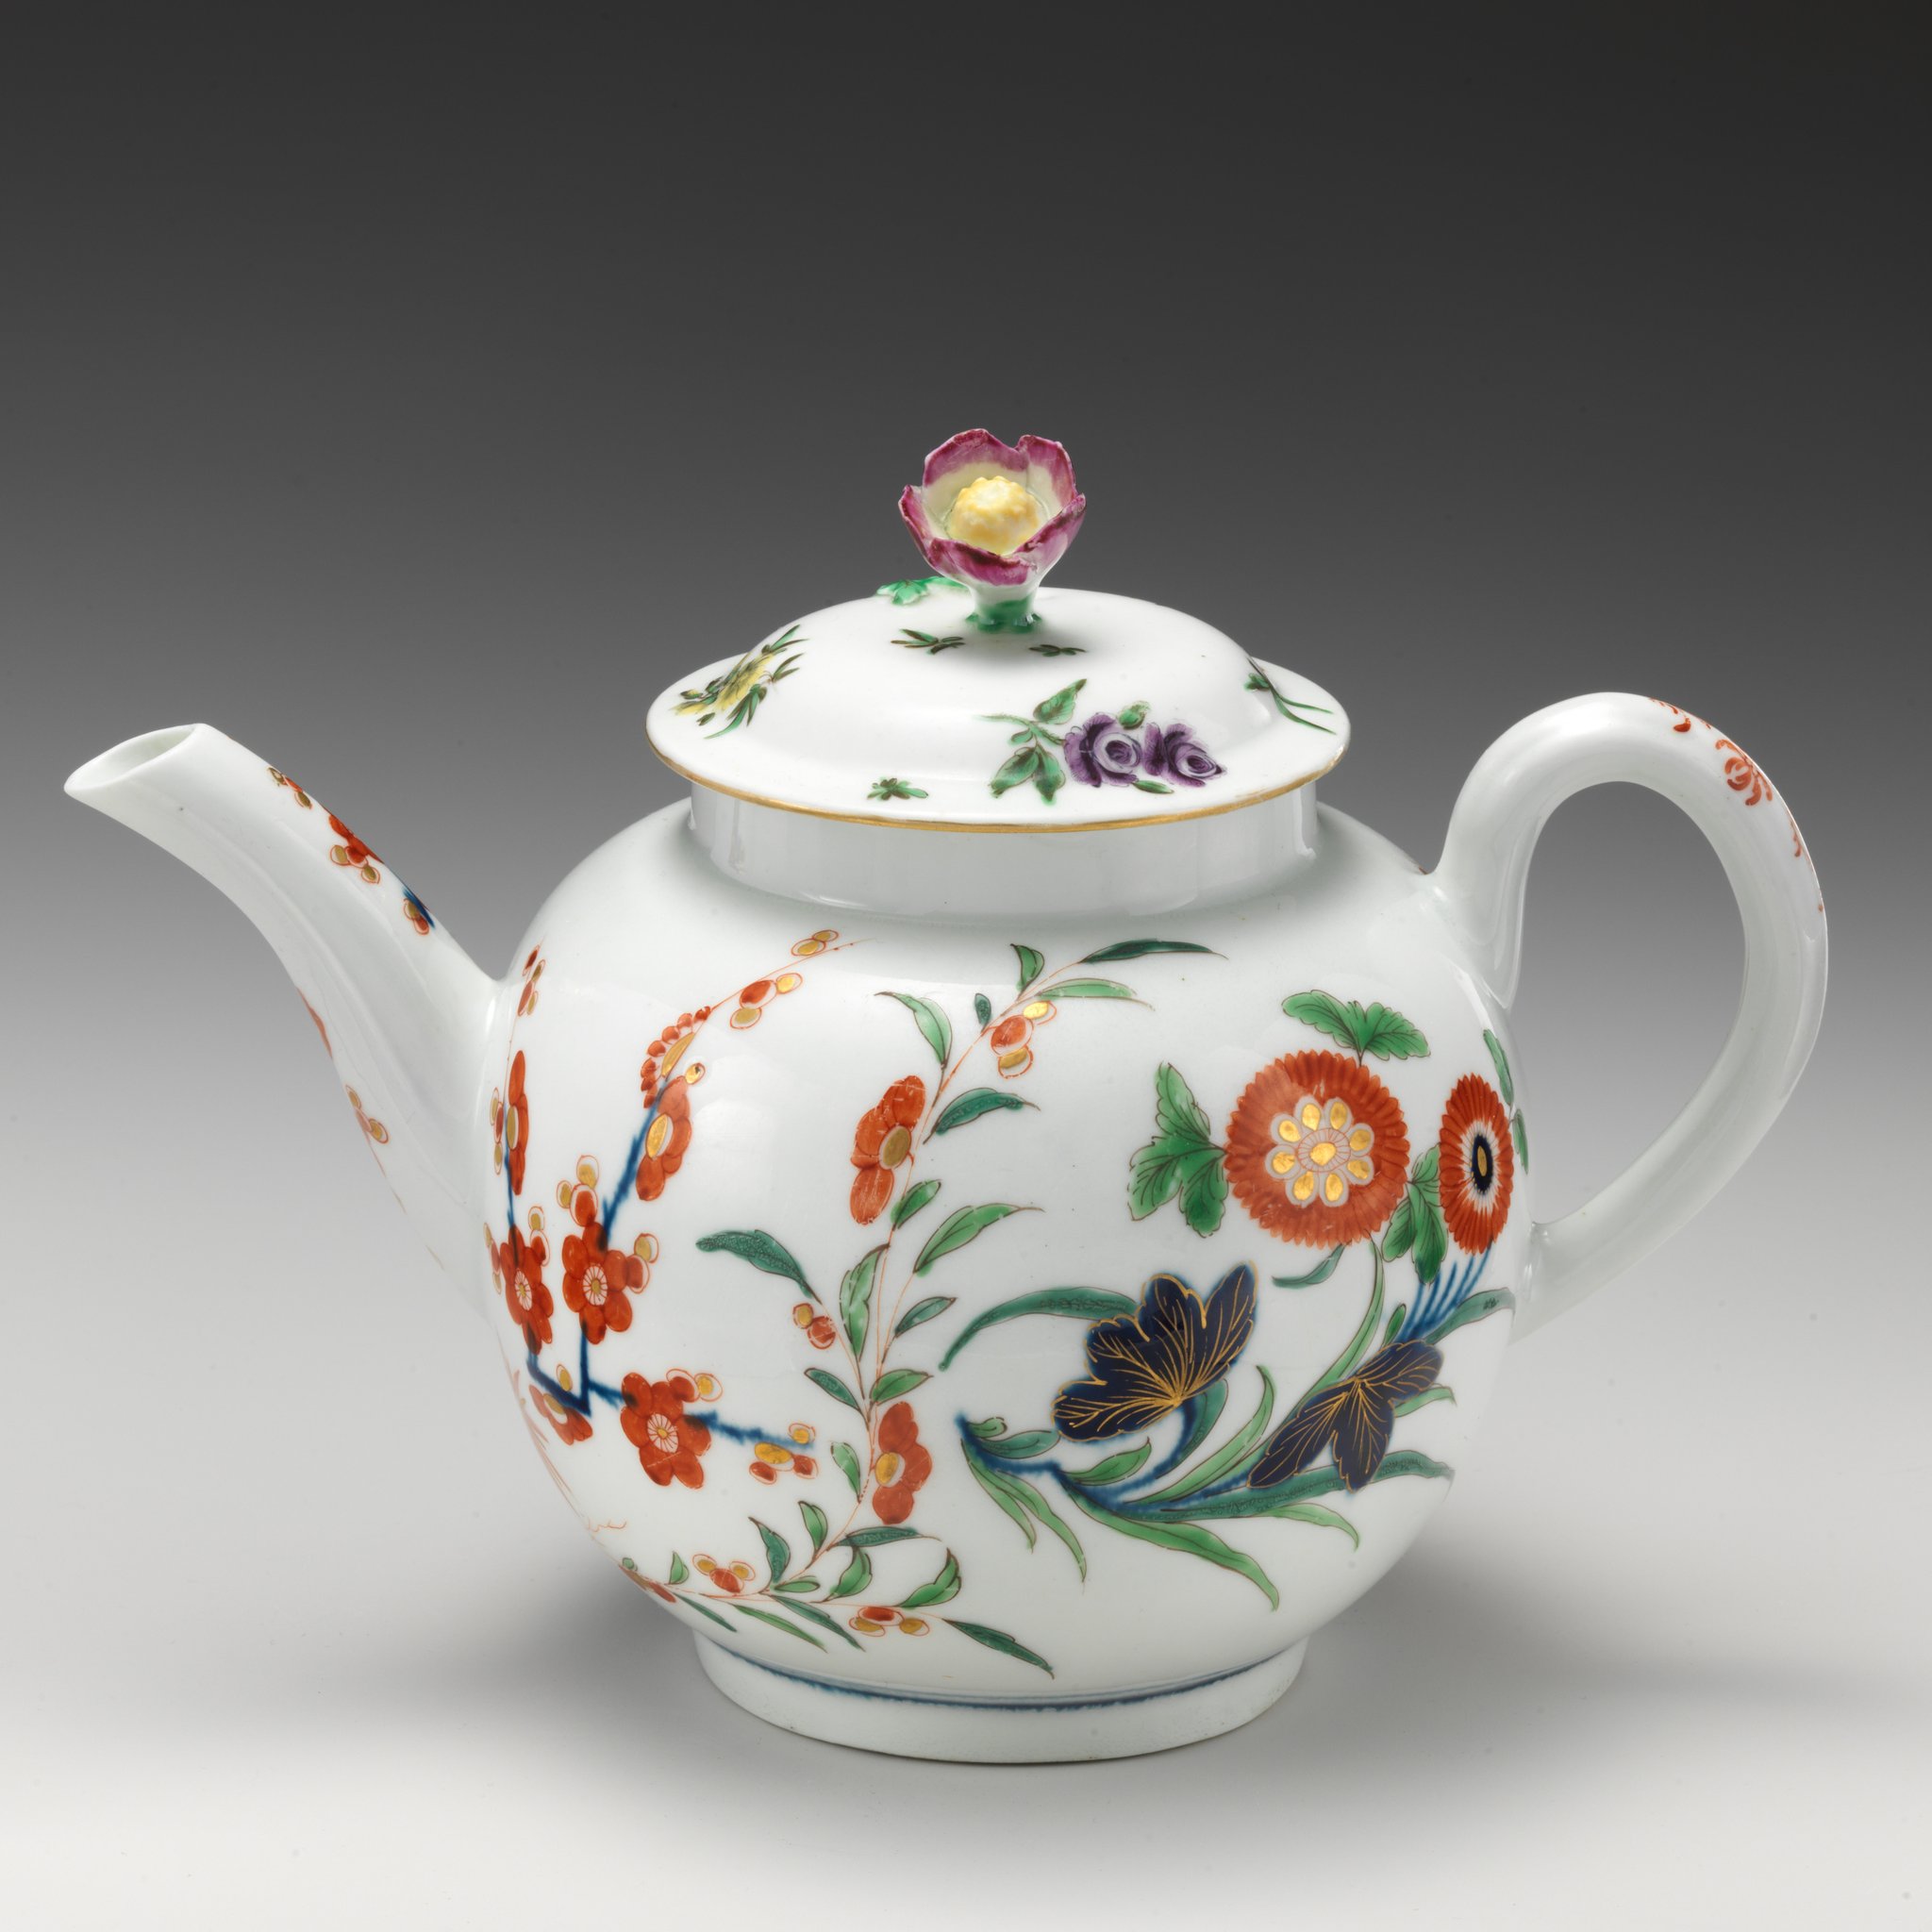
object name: teapot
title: Teapot (part of a service)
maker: worcester factory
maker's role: factory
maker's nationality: british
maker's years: 1751-2008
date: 1765-1770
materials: enamel, soft paste porcelain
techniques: gilding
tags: flowers